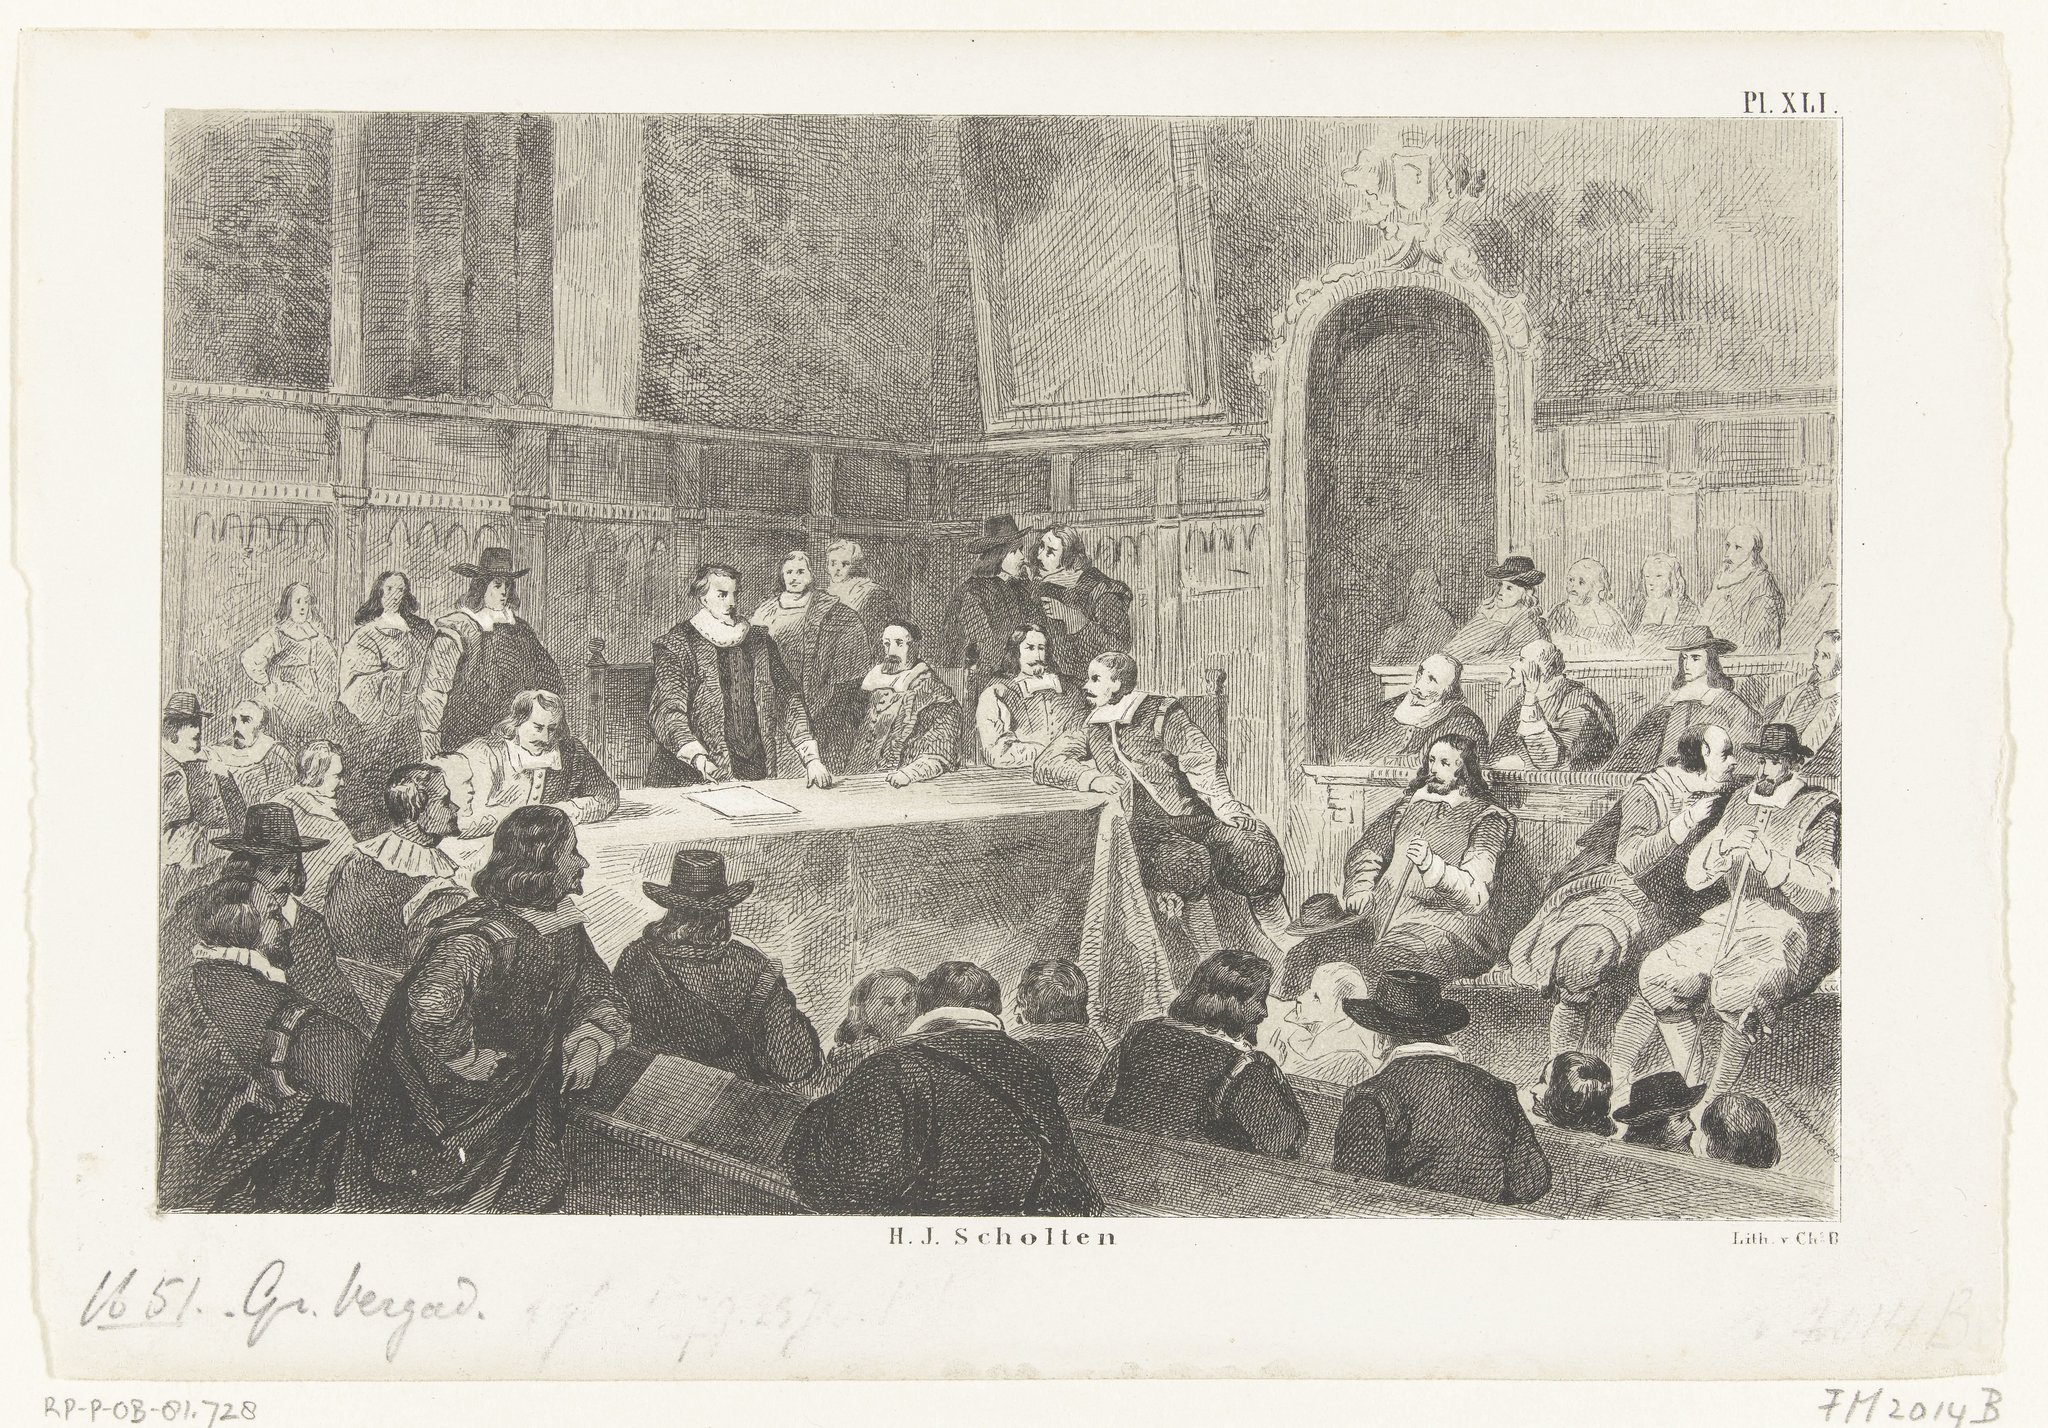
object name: print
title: De Eerste Grote Vergadering, 1651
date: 1853-1861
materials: paper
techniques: tone lithography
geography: netherlands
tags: the hague, jacob cats (1577-1660), lower house, parliament, chamber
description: Gebruikt als illustratie in: Jacob van Lennep, De geschiedenis des vaderlands in schetsen en afbeeldingen, Binger, Amsterdam 1855-1861, 8 delen, pl. XLI. Dit nummer is een door het RPK toegevoegd nummer en staat niet in Frederik Muller, het werk waar de prent voor is gemaakt of uit afkomstig is, staat wel vermeld in Frederik Muller.